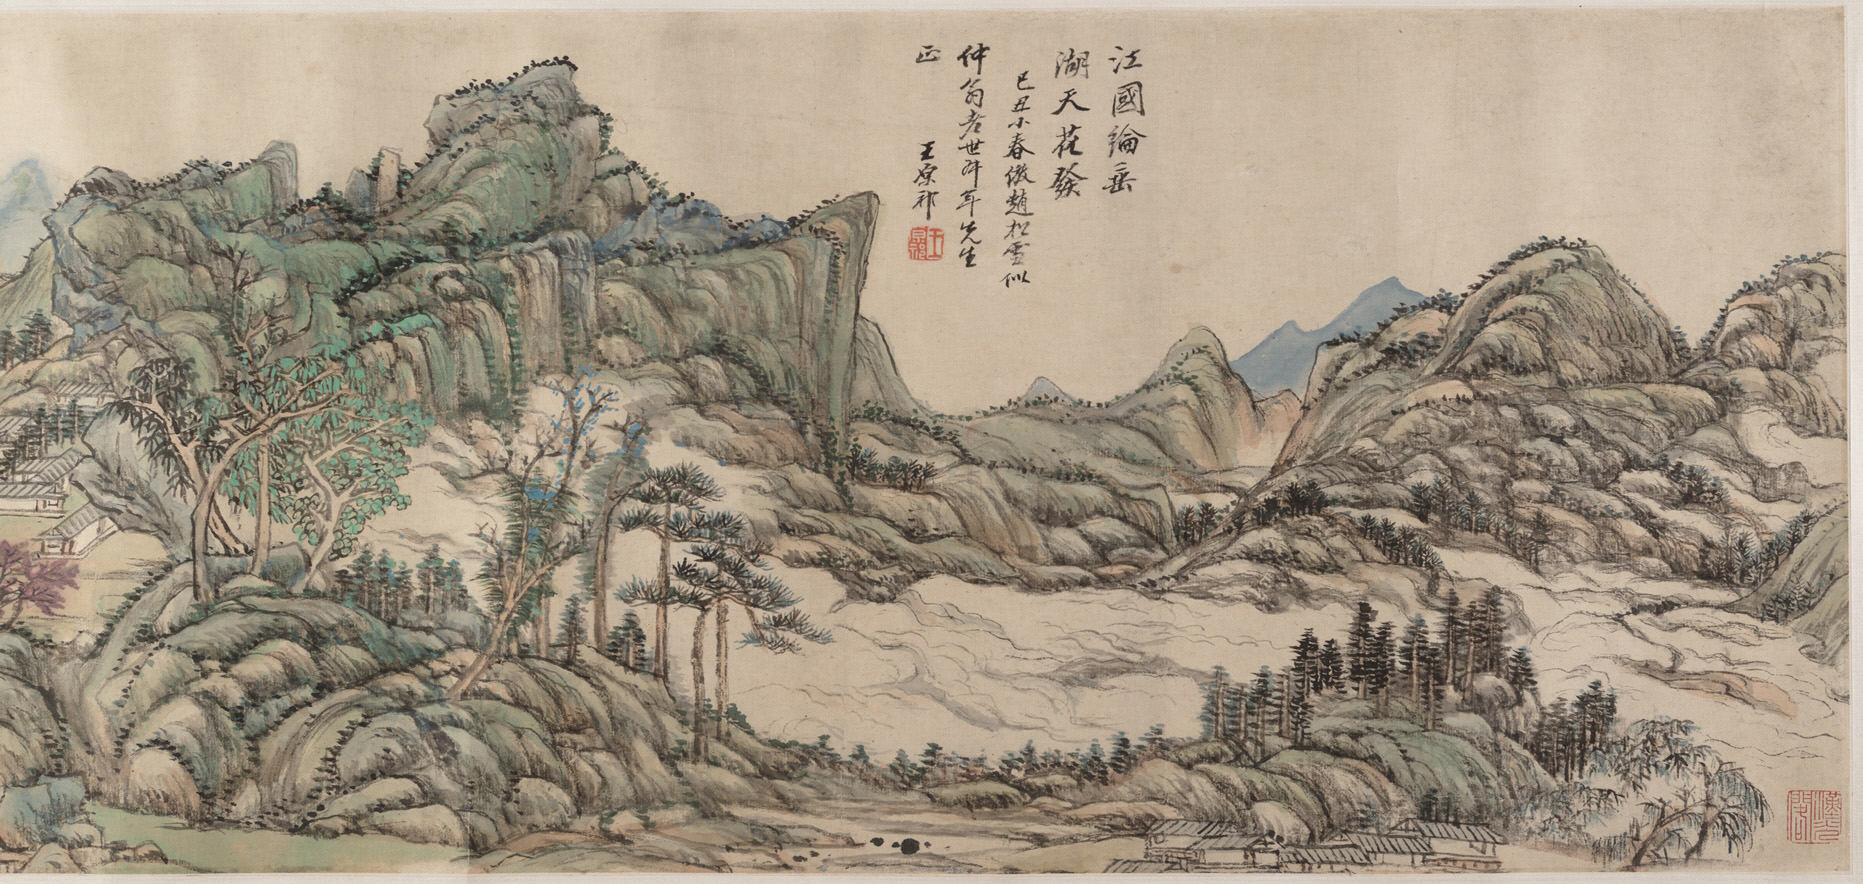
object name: handscroll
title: Fishing in River Country at Blossom Time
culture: chinese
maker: wang yuanqi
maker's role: artist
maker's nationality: chinese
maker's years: 1642-1715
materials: ink, paper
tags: rivers,mountains,landscapes